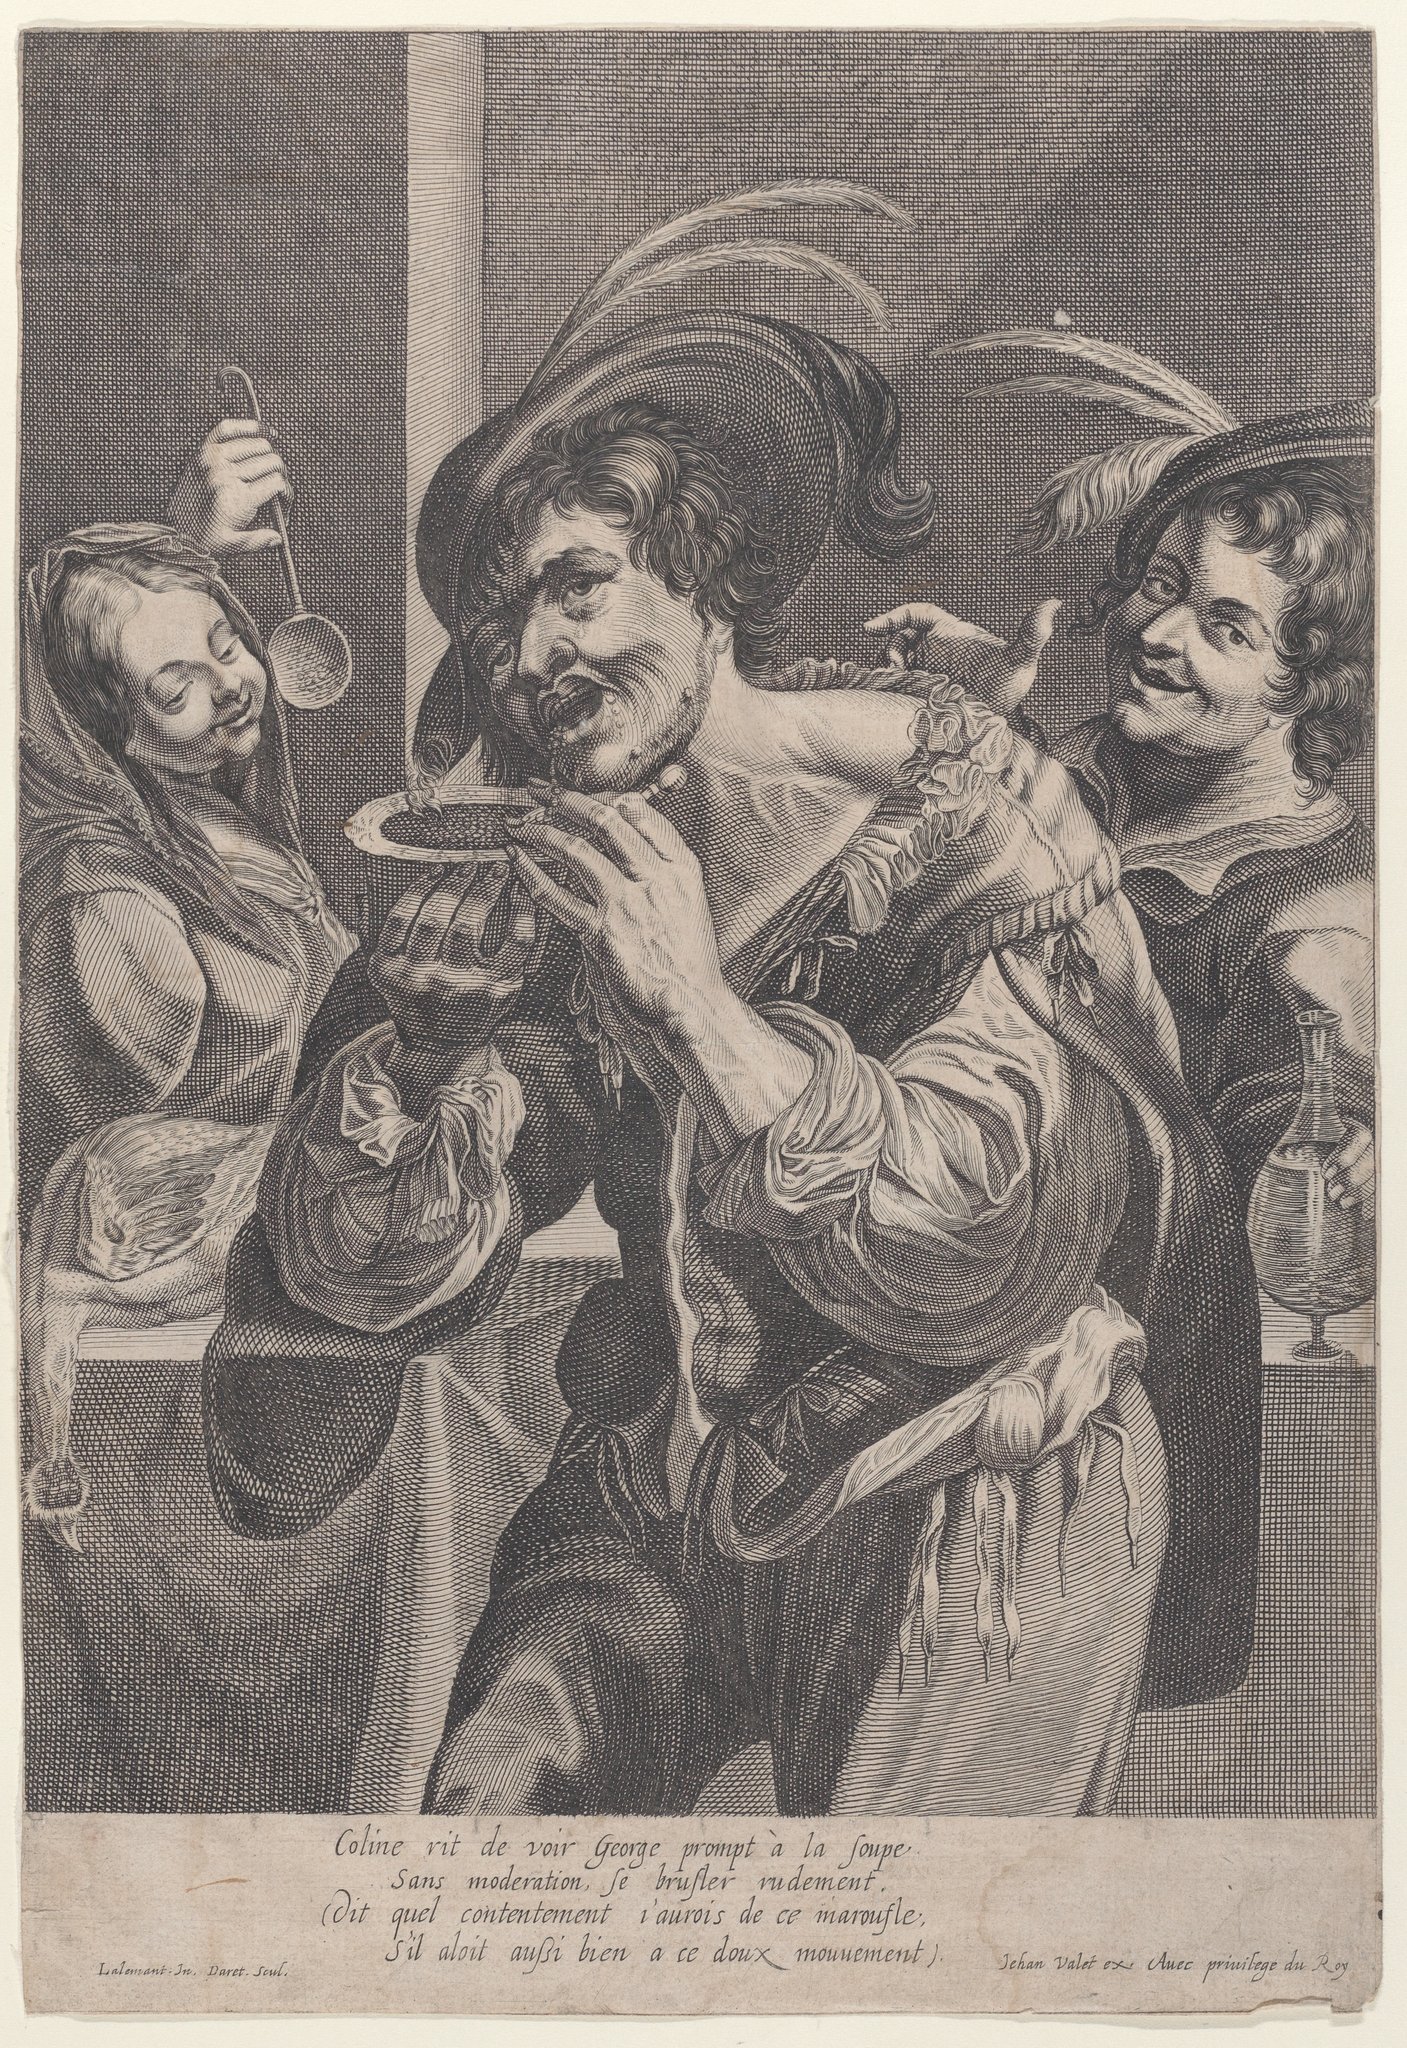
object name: print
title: Man drinking soup while two people watch him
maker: pierre daret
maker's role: artist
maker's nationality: french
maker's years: 1604-1675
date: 1624-1675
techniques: engraving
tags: food,men,women,eating